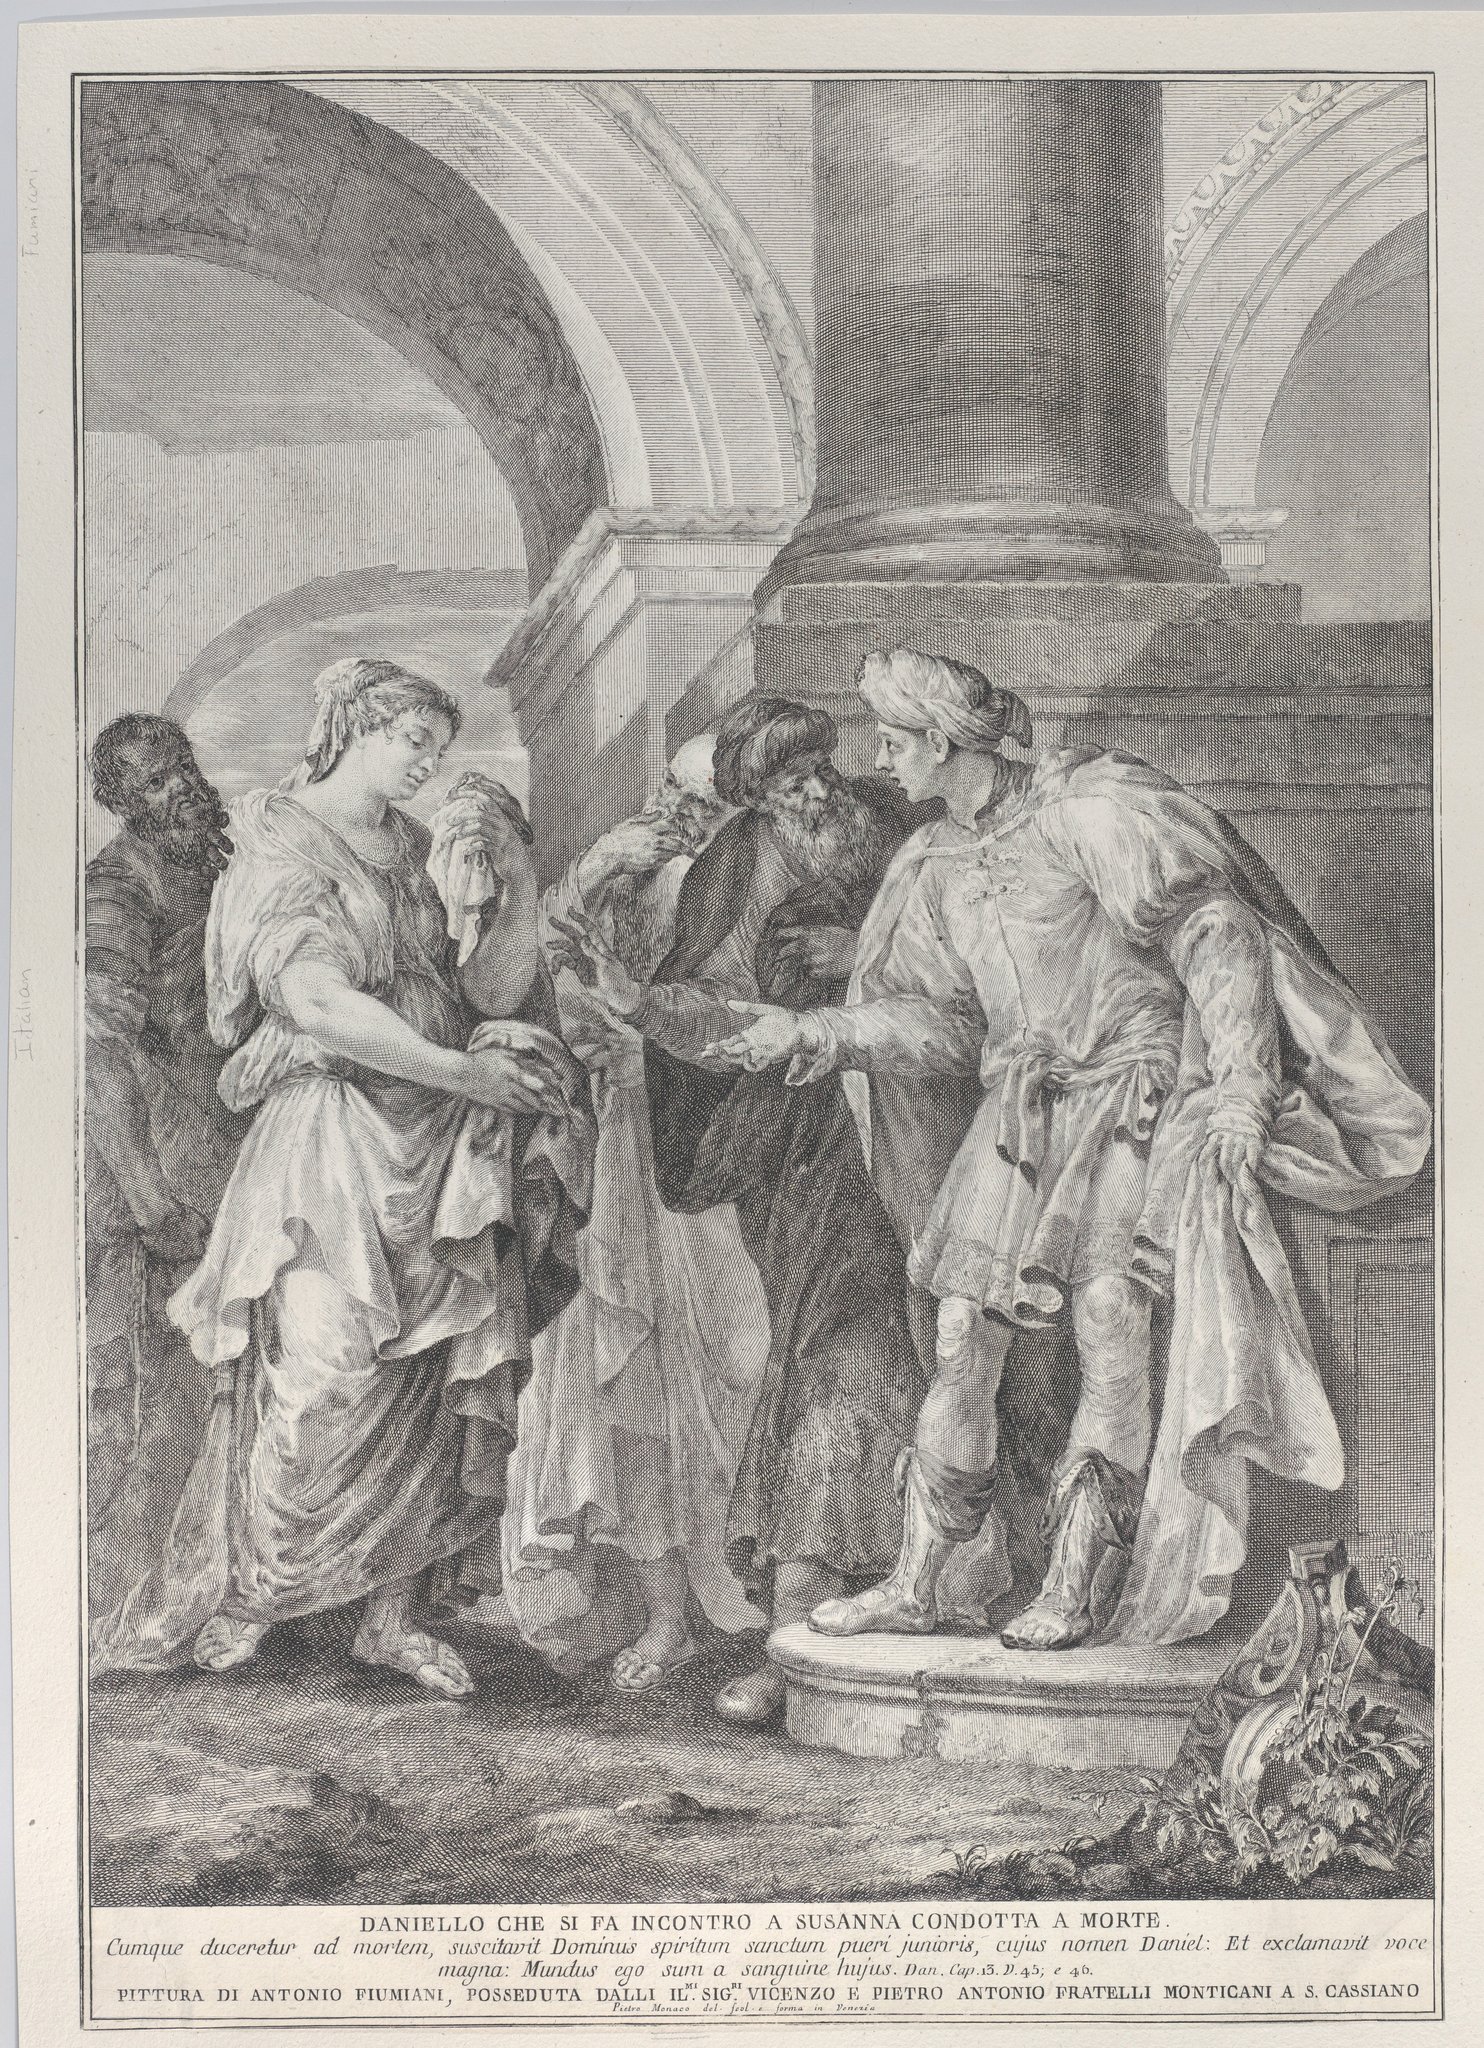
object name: print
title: Daniel argues with the elders while Susanna stands at left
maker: pietro monaco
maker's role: artist and publisher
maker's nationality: italian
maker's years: 1707-1772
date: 1732-1750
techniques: engraving, etching